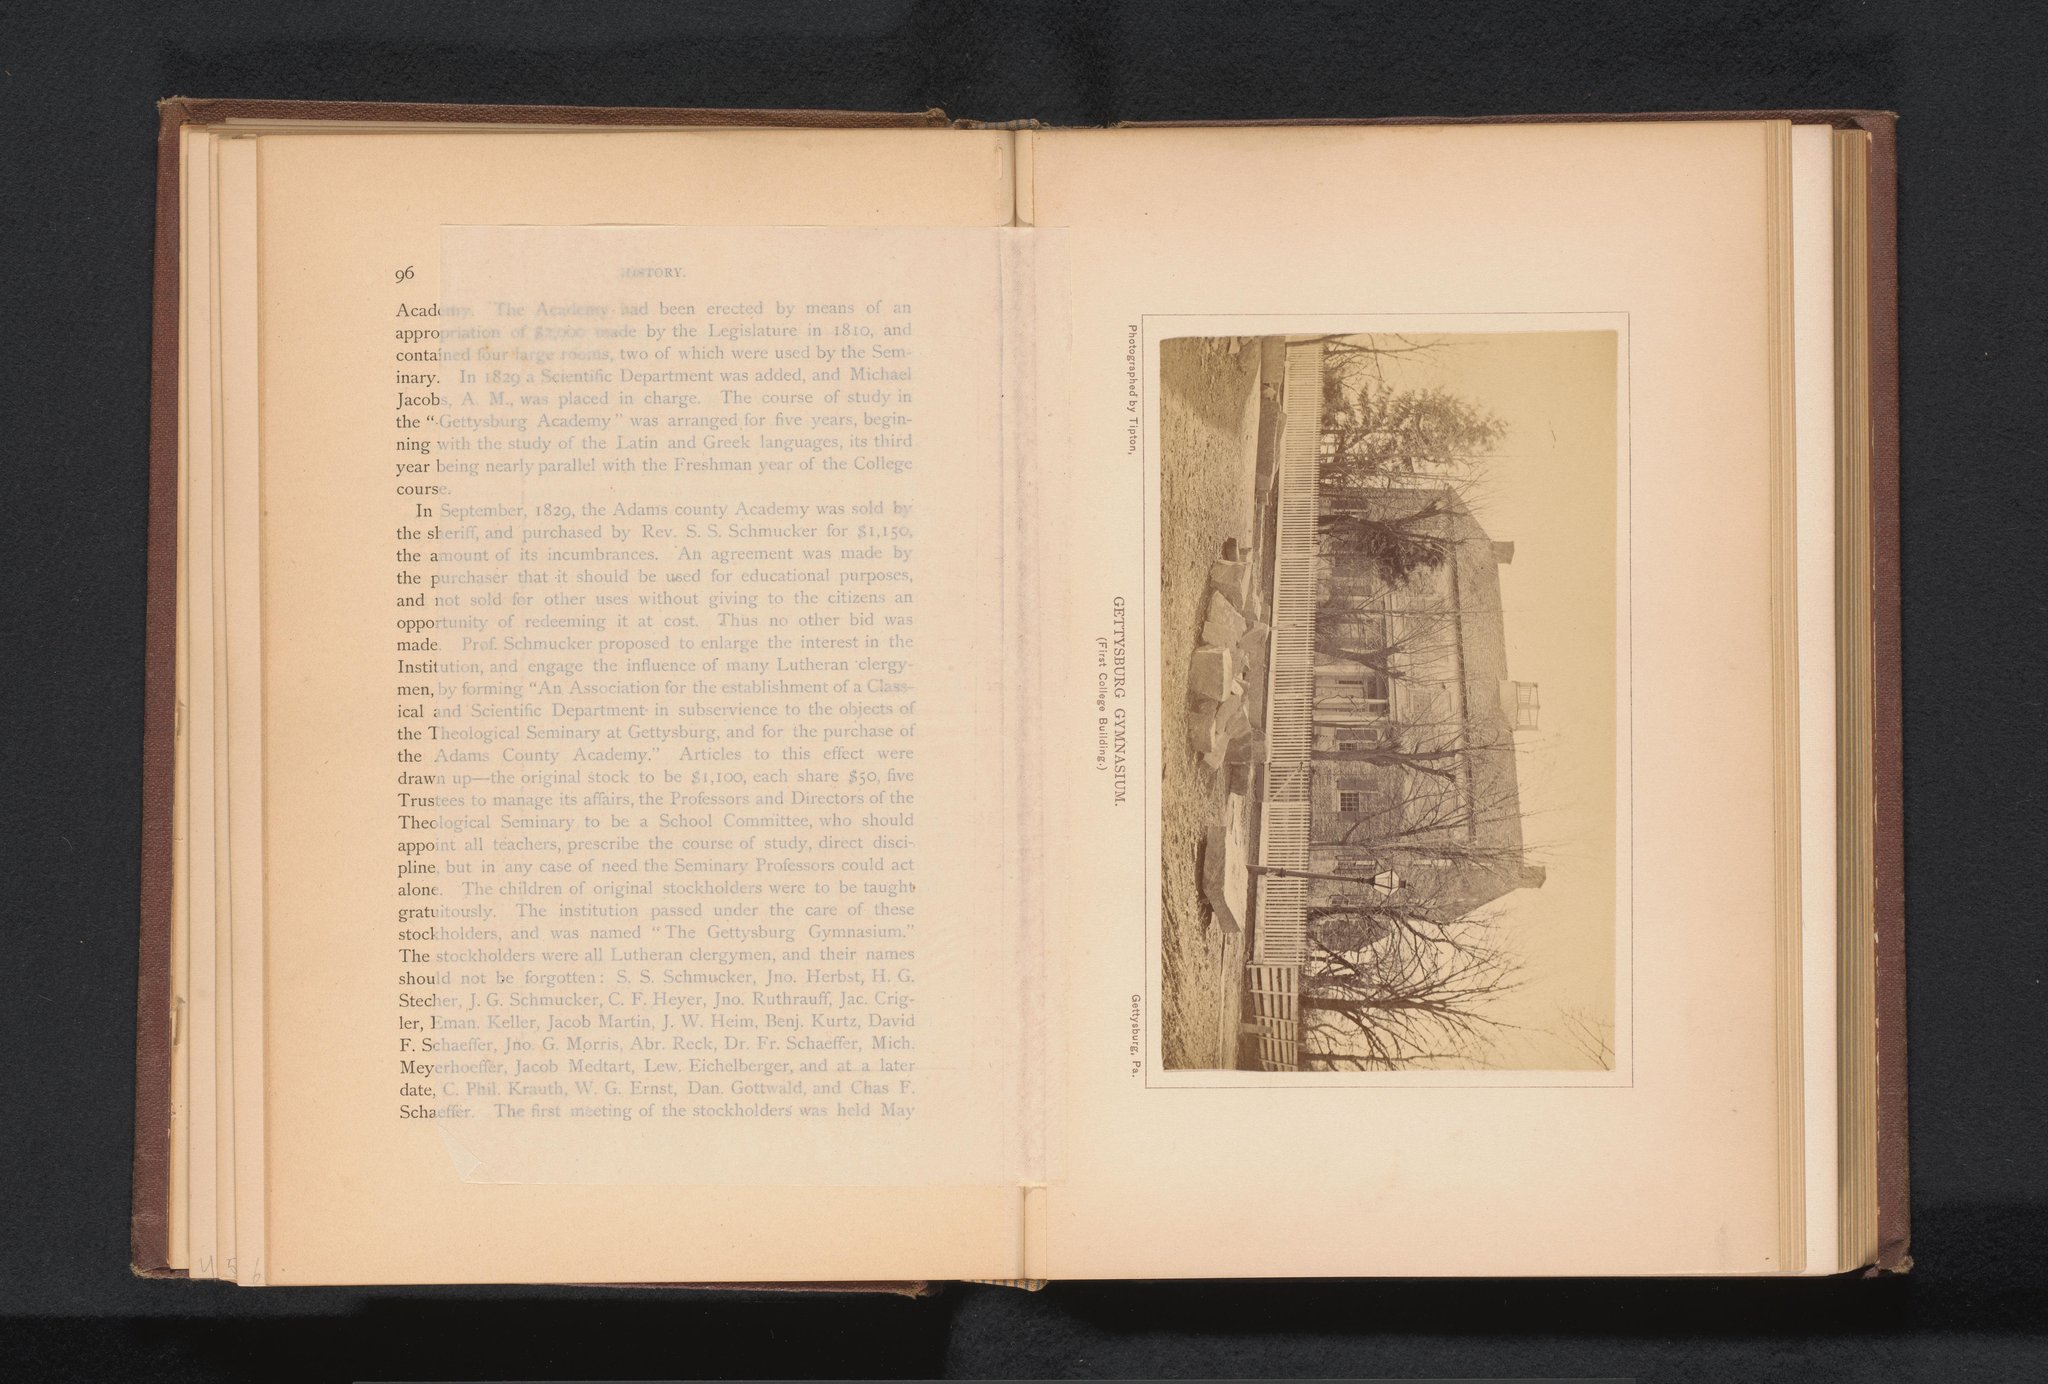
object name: page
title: Gettysburg gymnasium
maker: william h. tipton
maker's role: fotograaf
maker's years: 1850-1920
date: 1877-1882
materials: photographic support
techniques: albumen print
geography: gettysburg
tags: university building, college, façade (of house or building)